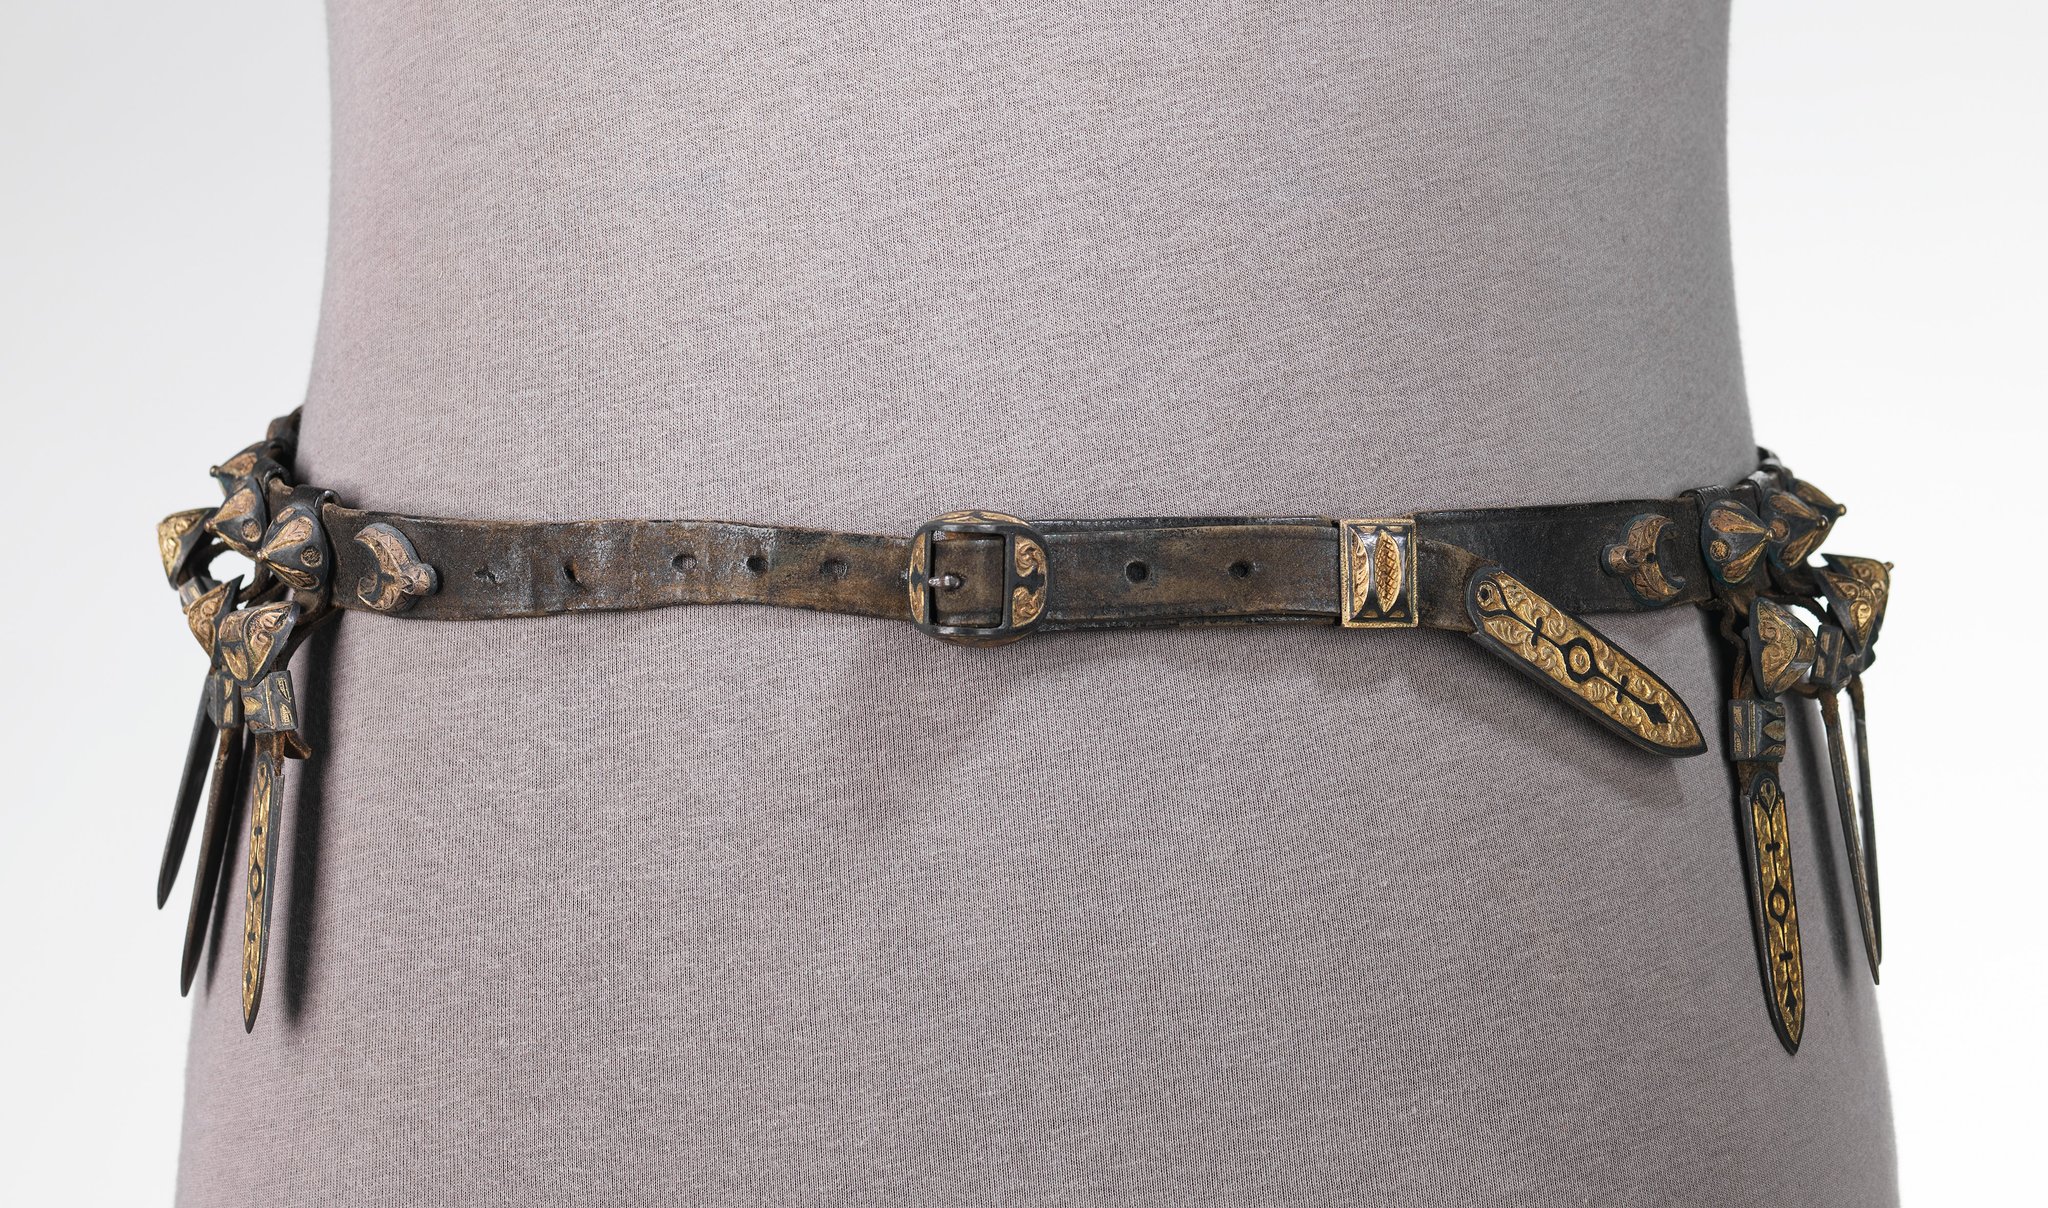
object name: belt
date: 1801-1825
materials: leather, metal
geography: russia